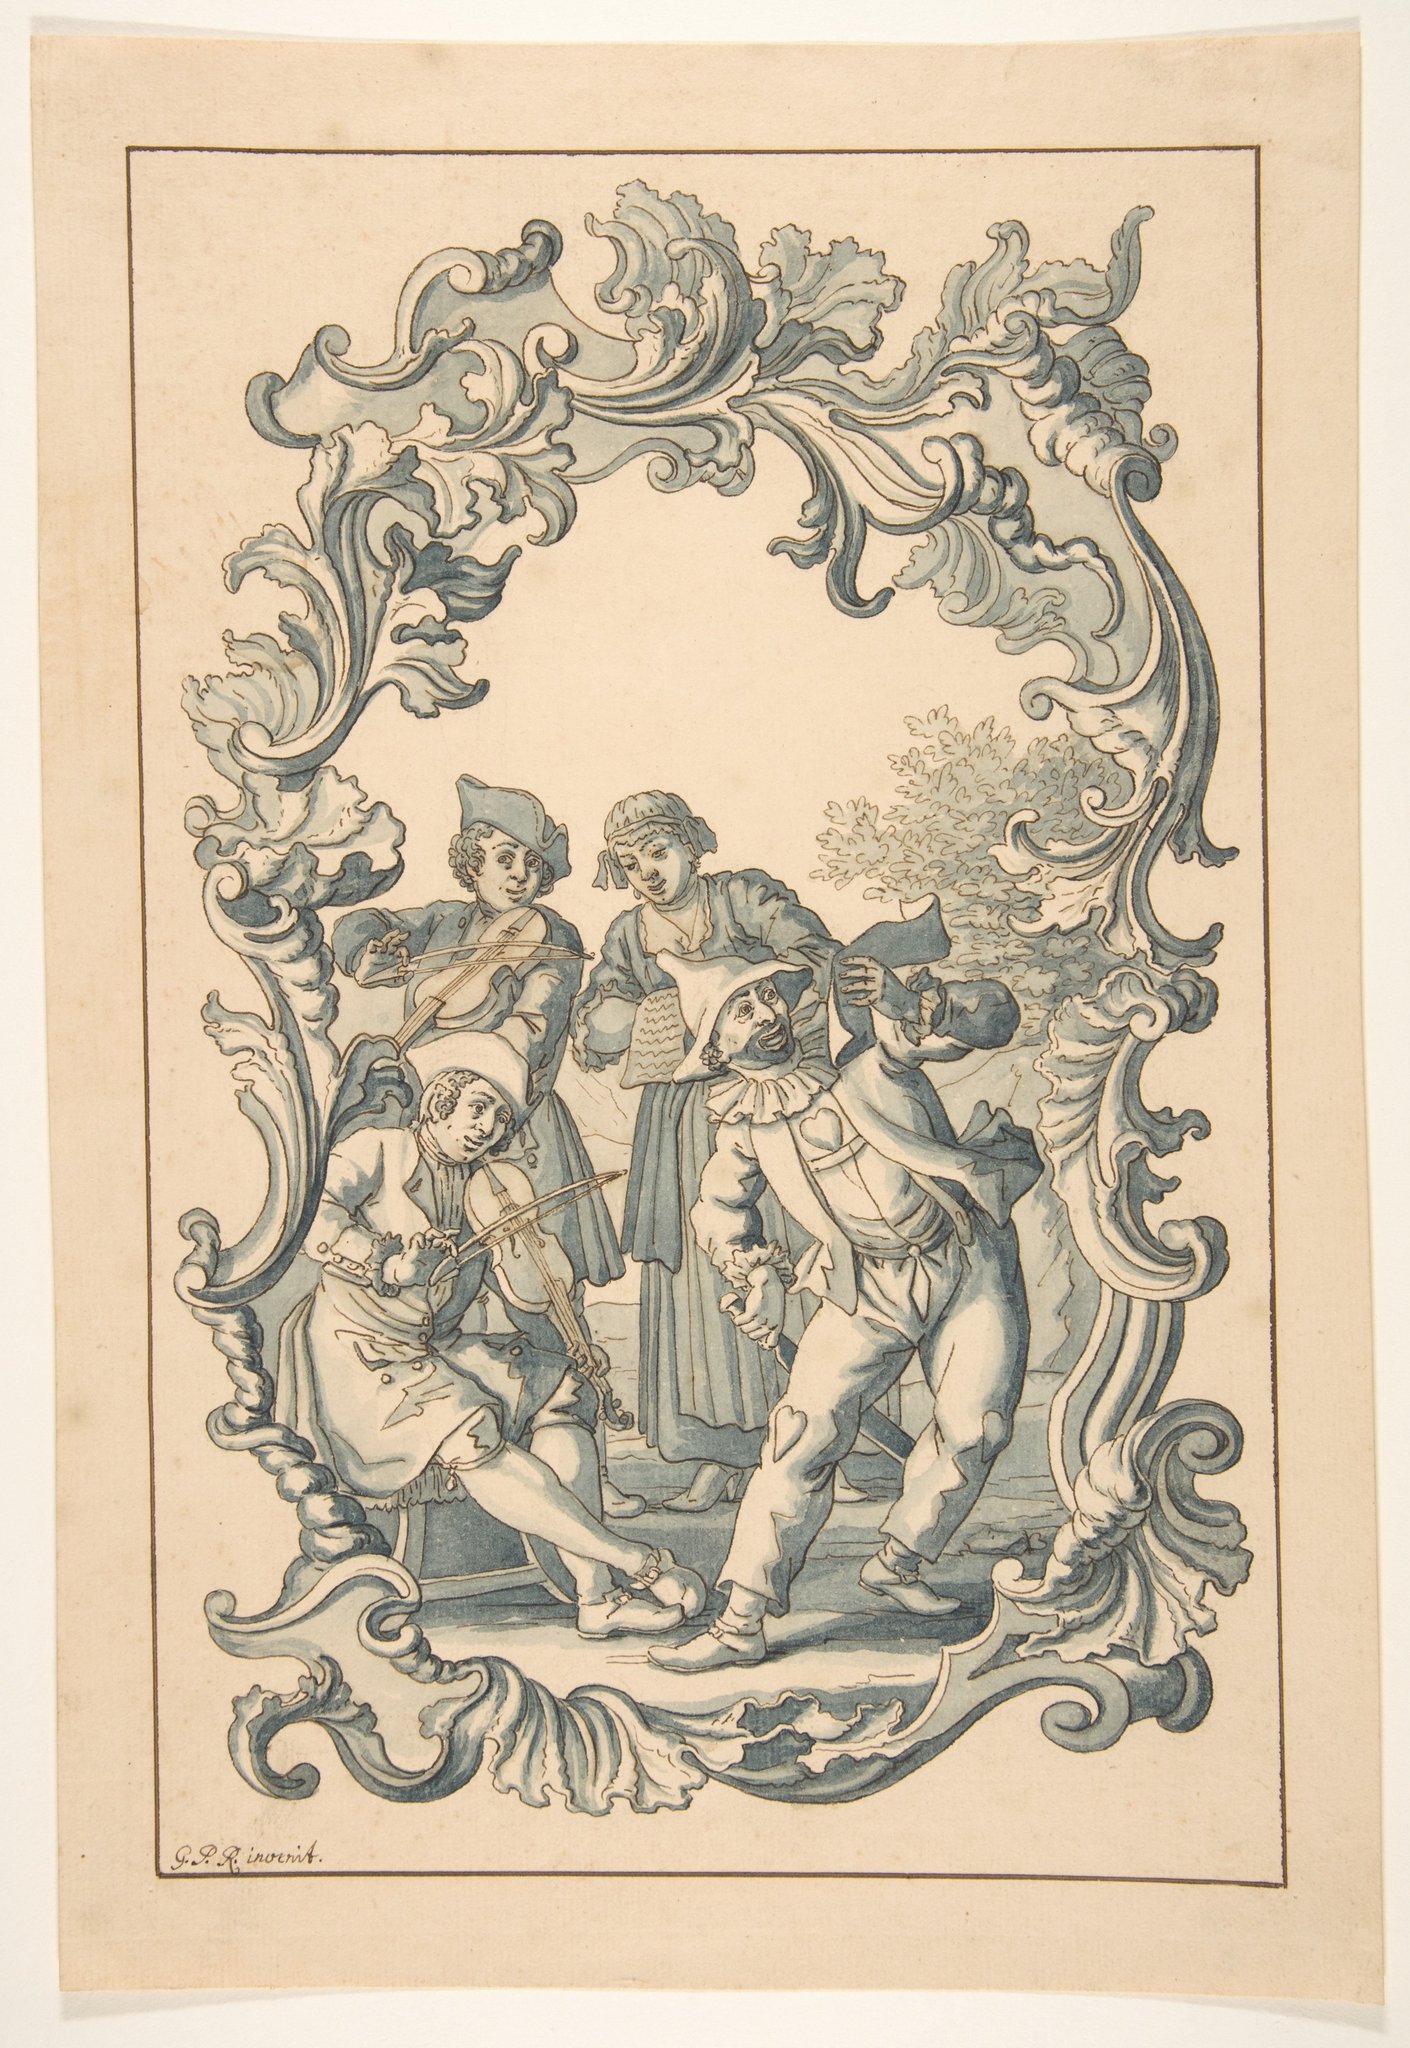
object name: drawing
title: Three Musicians and Harlequin in an Ornamental Frame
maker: georg philipp rugendas ii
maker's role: artist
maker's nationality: german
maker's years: 1701-1774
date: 1720-1774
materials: ink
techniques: brush, pen, wash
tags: musical instruments,ornament,men,musicians